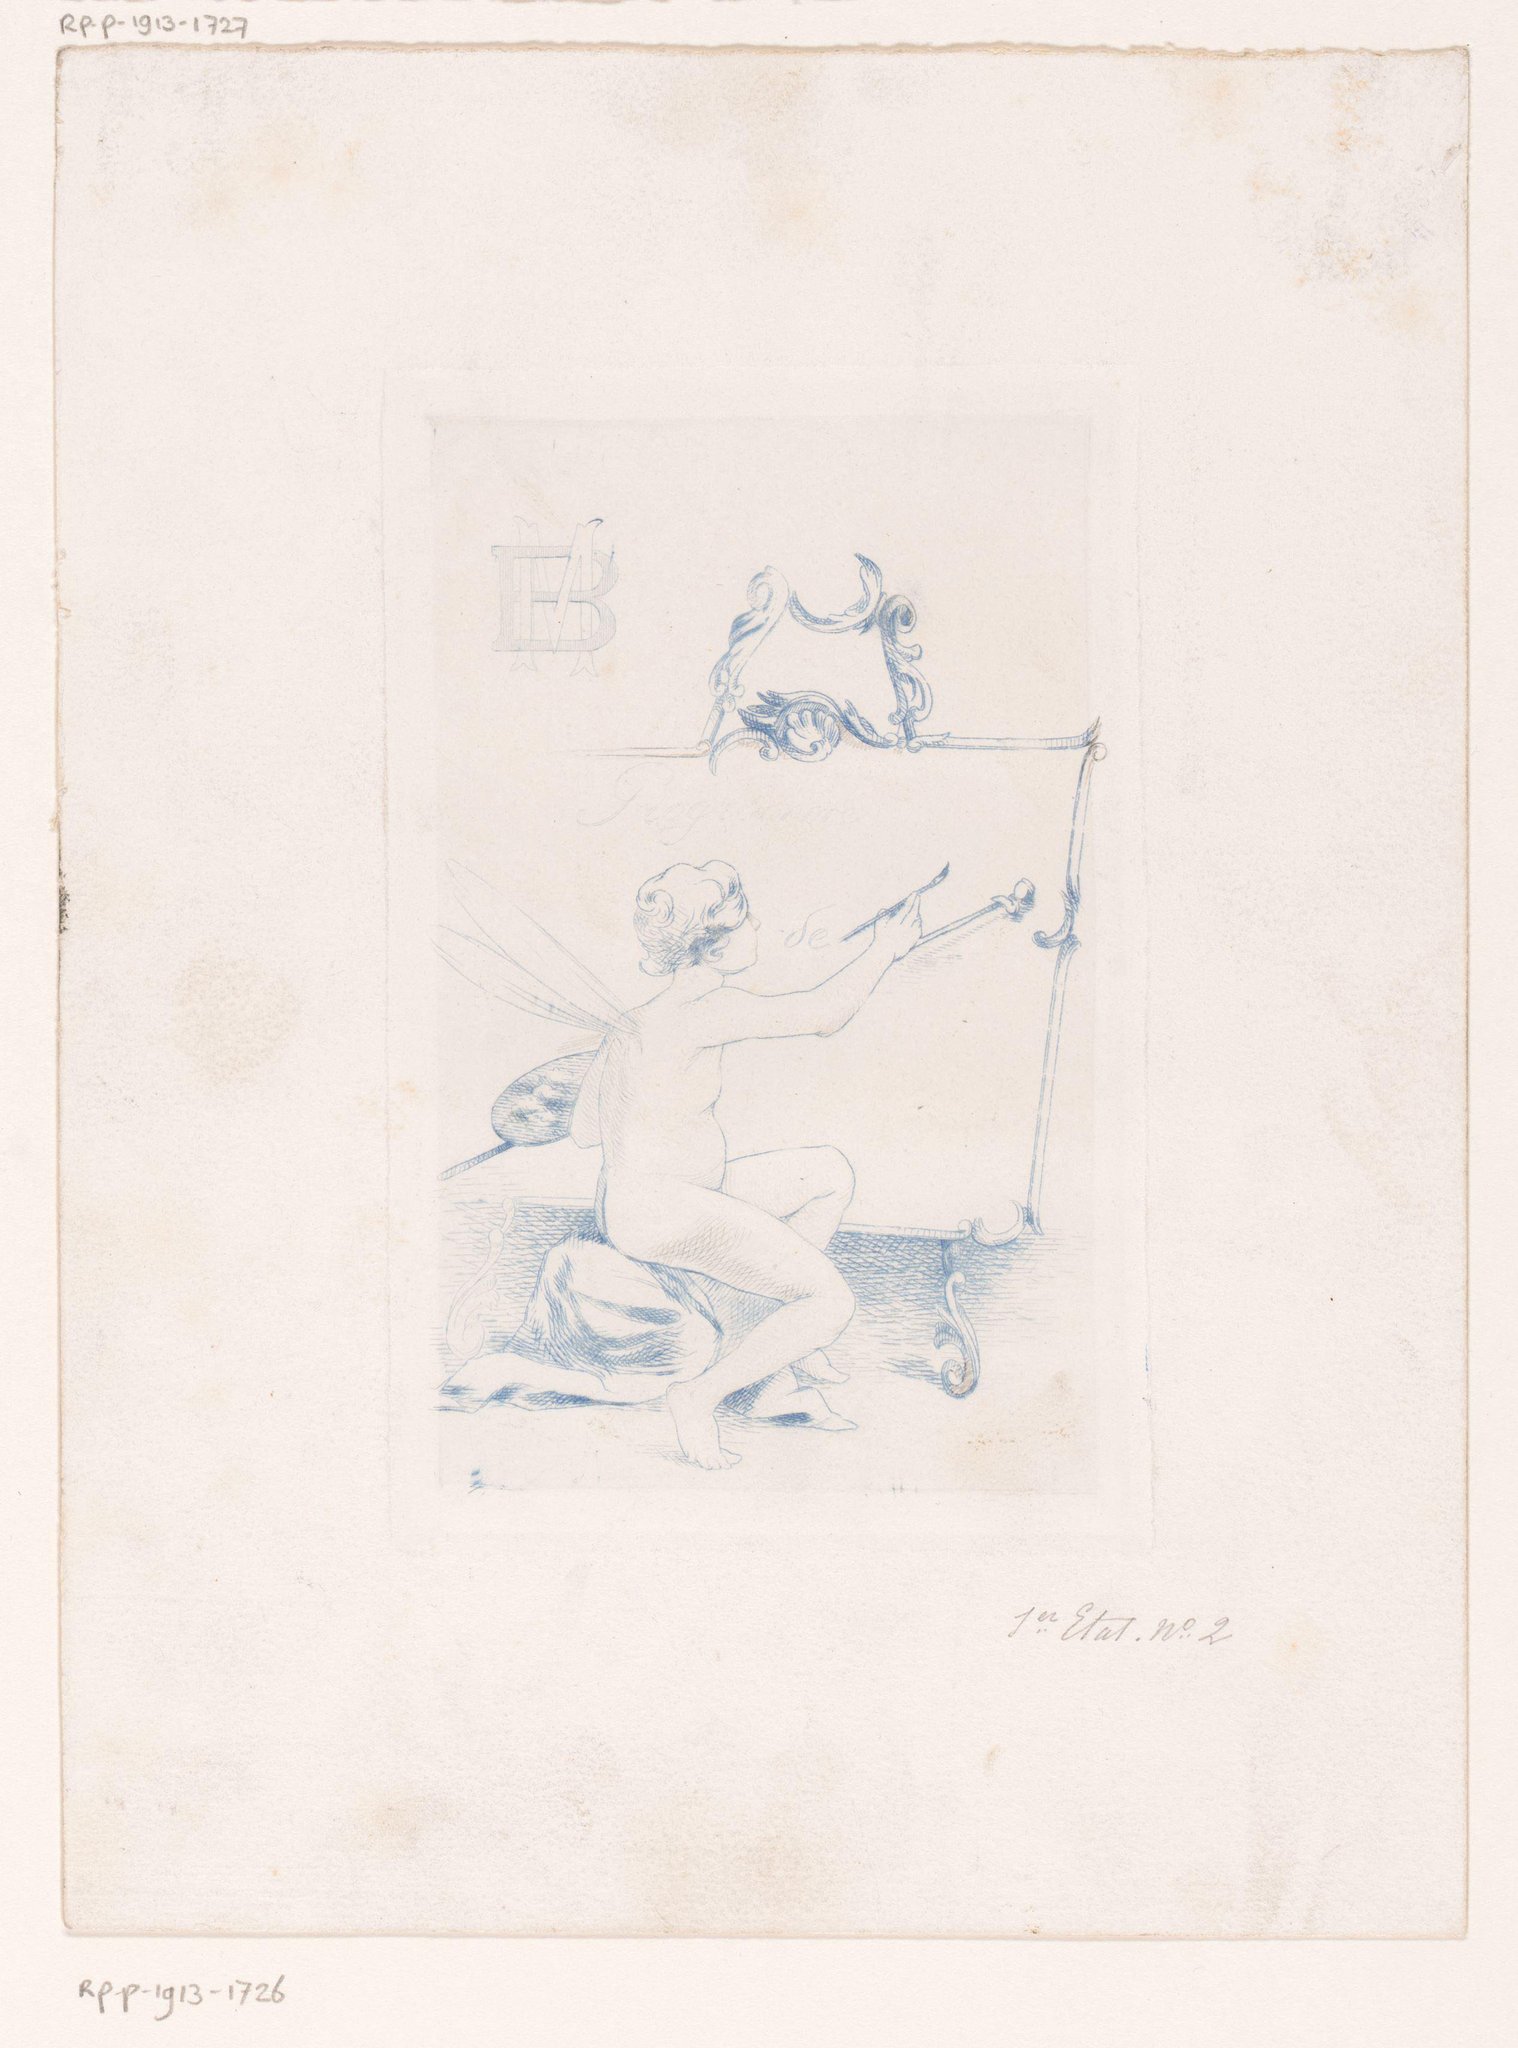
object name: titelblad, titelpagina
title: Titelpagina voor: Programme l'amour de l'art une Virgule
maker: marc henry meunier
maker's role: print maker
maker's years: 1873-1922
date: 1883-1913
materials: paper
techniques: etching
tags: palette, fabulous beings with wings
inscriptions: inscription: ‘1er Etat. No. 2’, collector's mark: Lugt 2228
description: Titelpagina voor: Programme l'amour de l'art une Virgule. S.l.s.n.s.a.